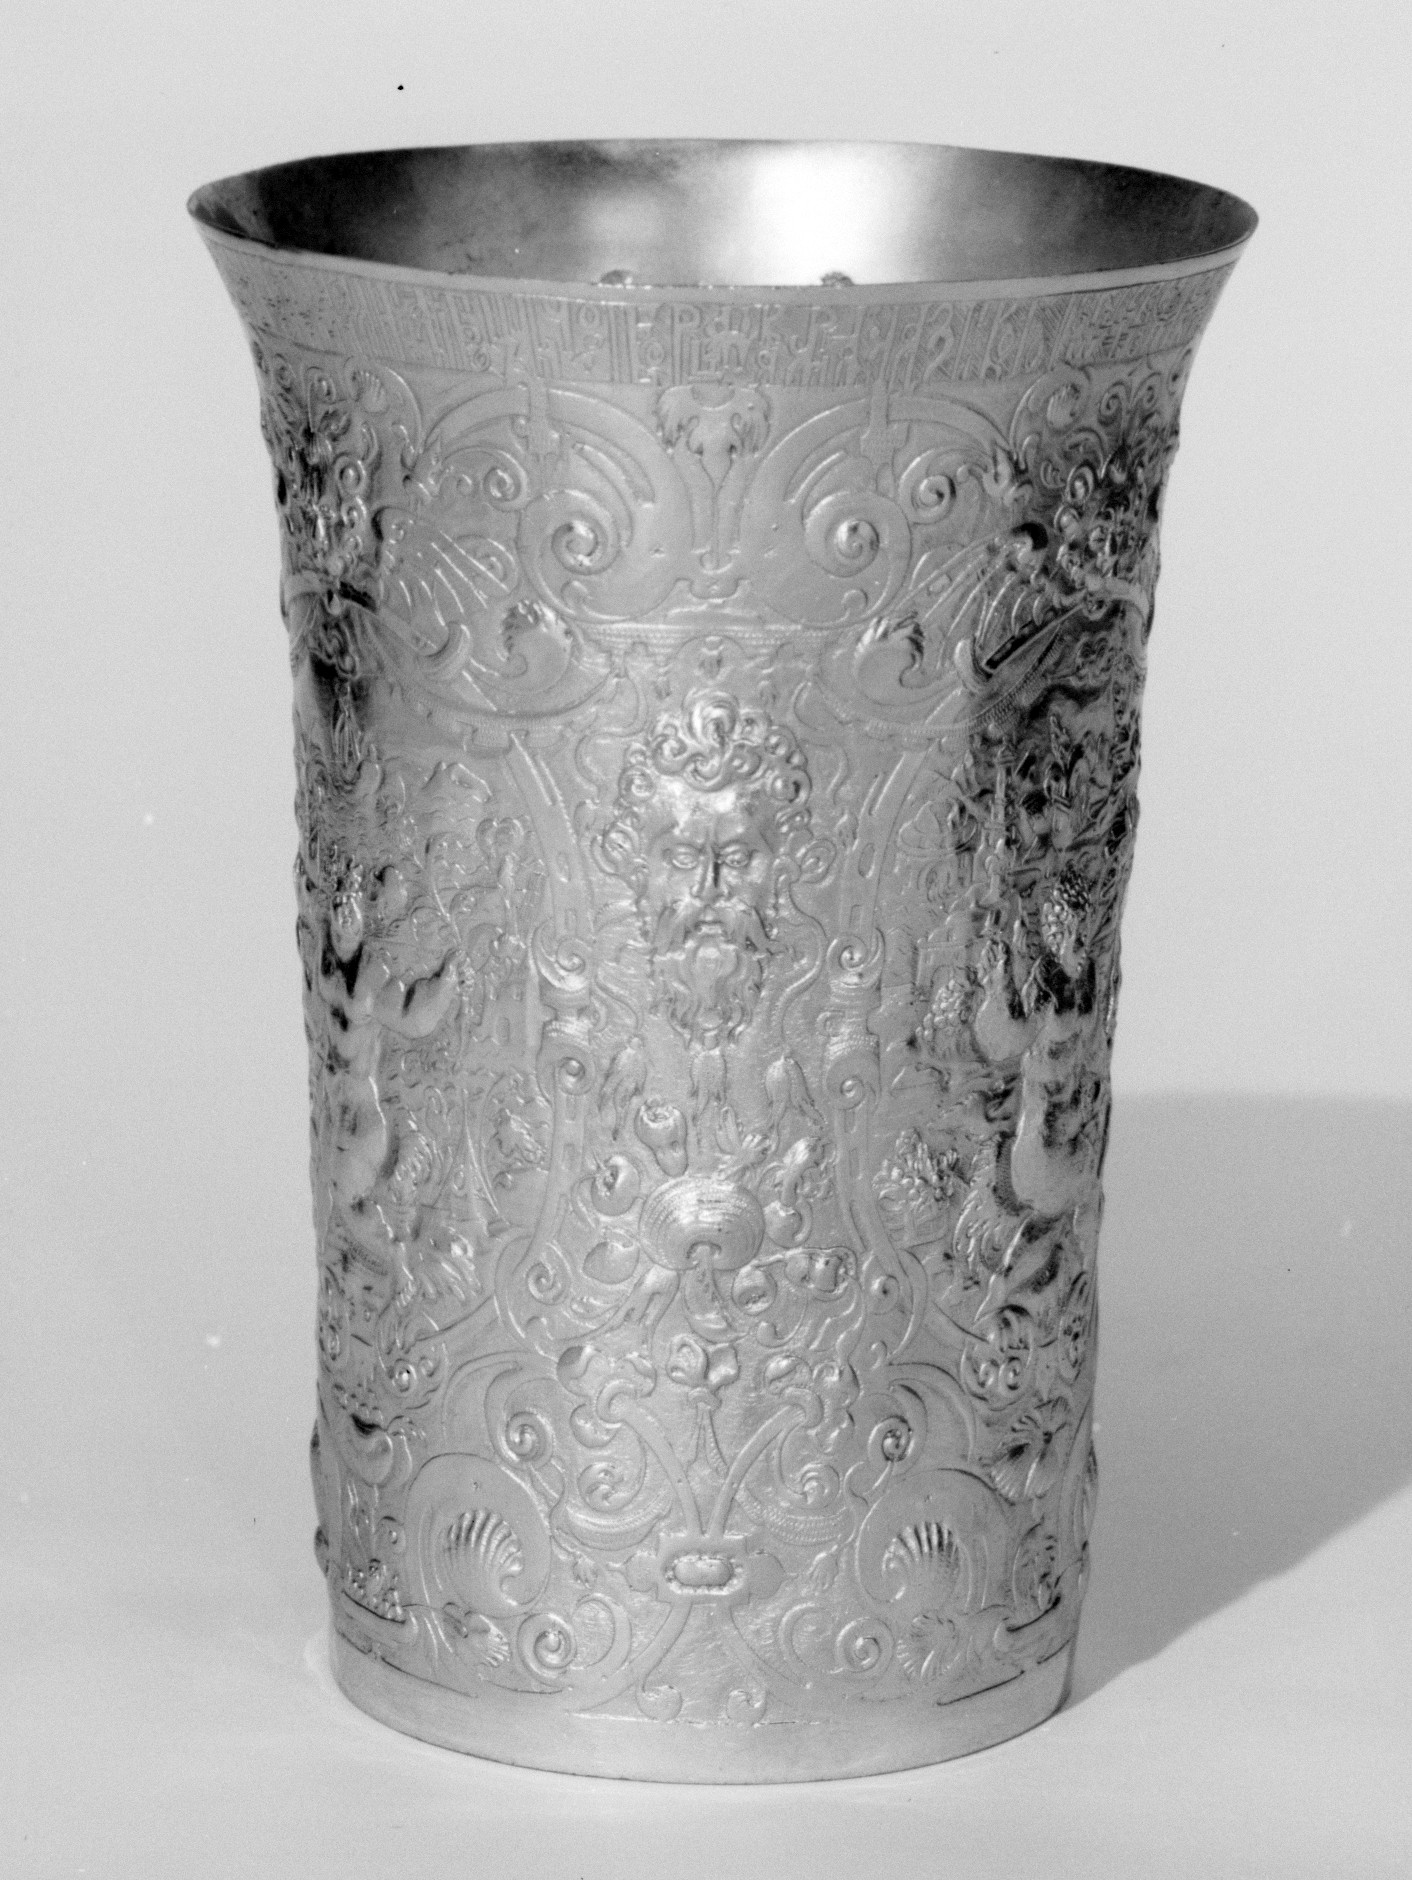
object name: beaker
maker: franchi and son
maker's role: manufacturer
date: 1801-1900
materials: metal, silver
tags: faces